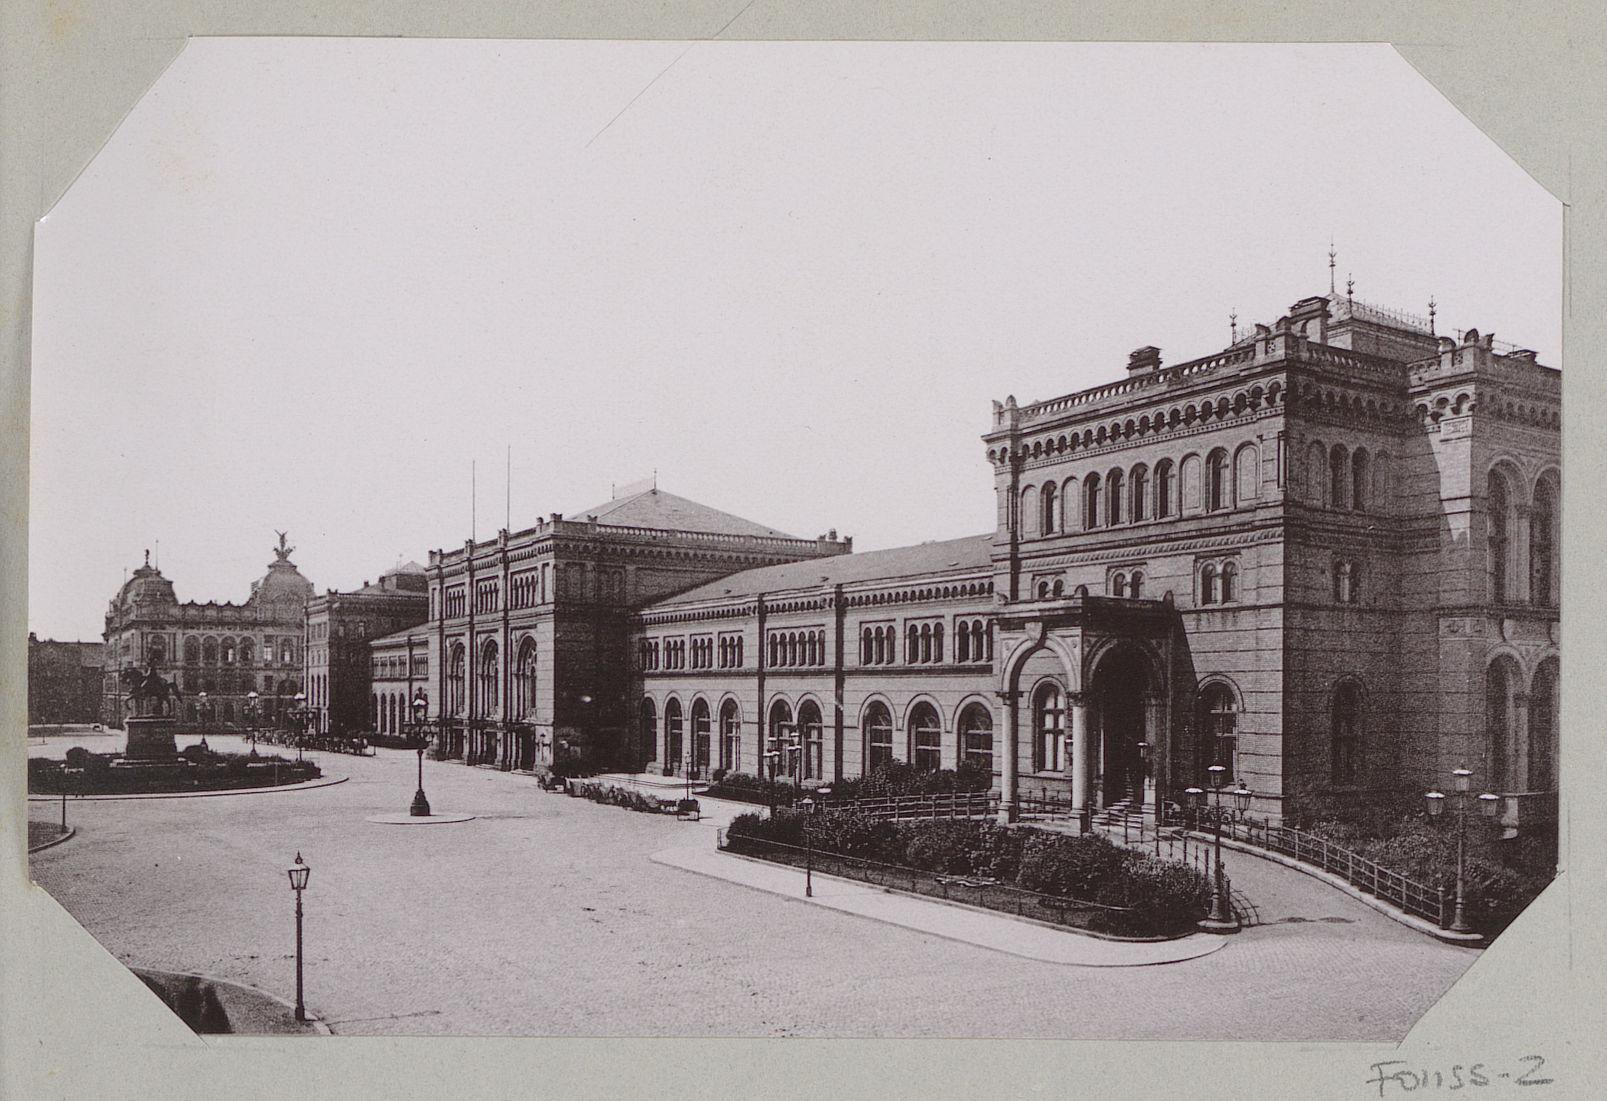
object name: album leaf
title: Gezicht op het treinstation te Hannover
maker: Anonymous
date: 1890-1897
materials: paper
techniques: photograph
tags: station; shelter (railway, tramway)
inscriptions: annotation: ‘Hannover/ Station’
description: Deze prent maakt deel uit van een album.